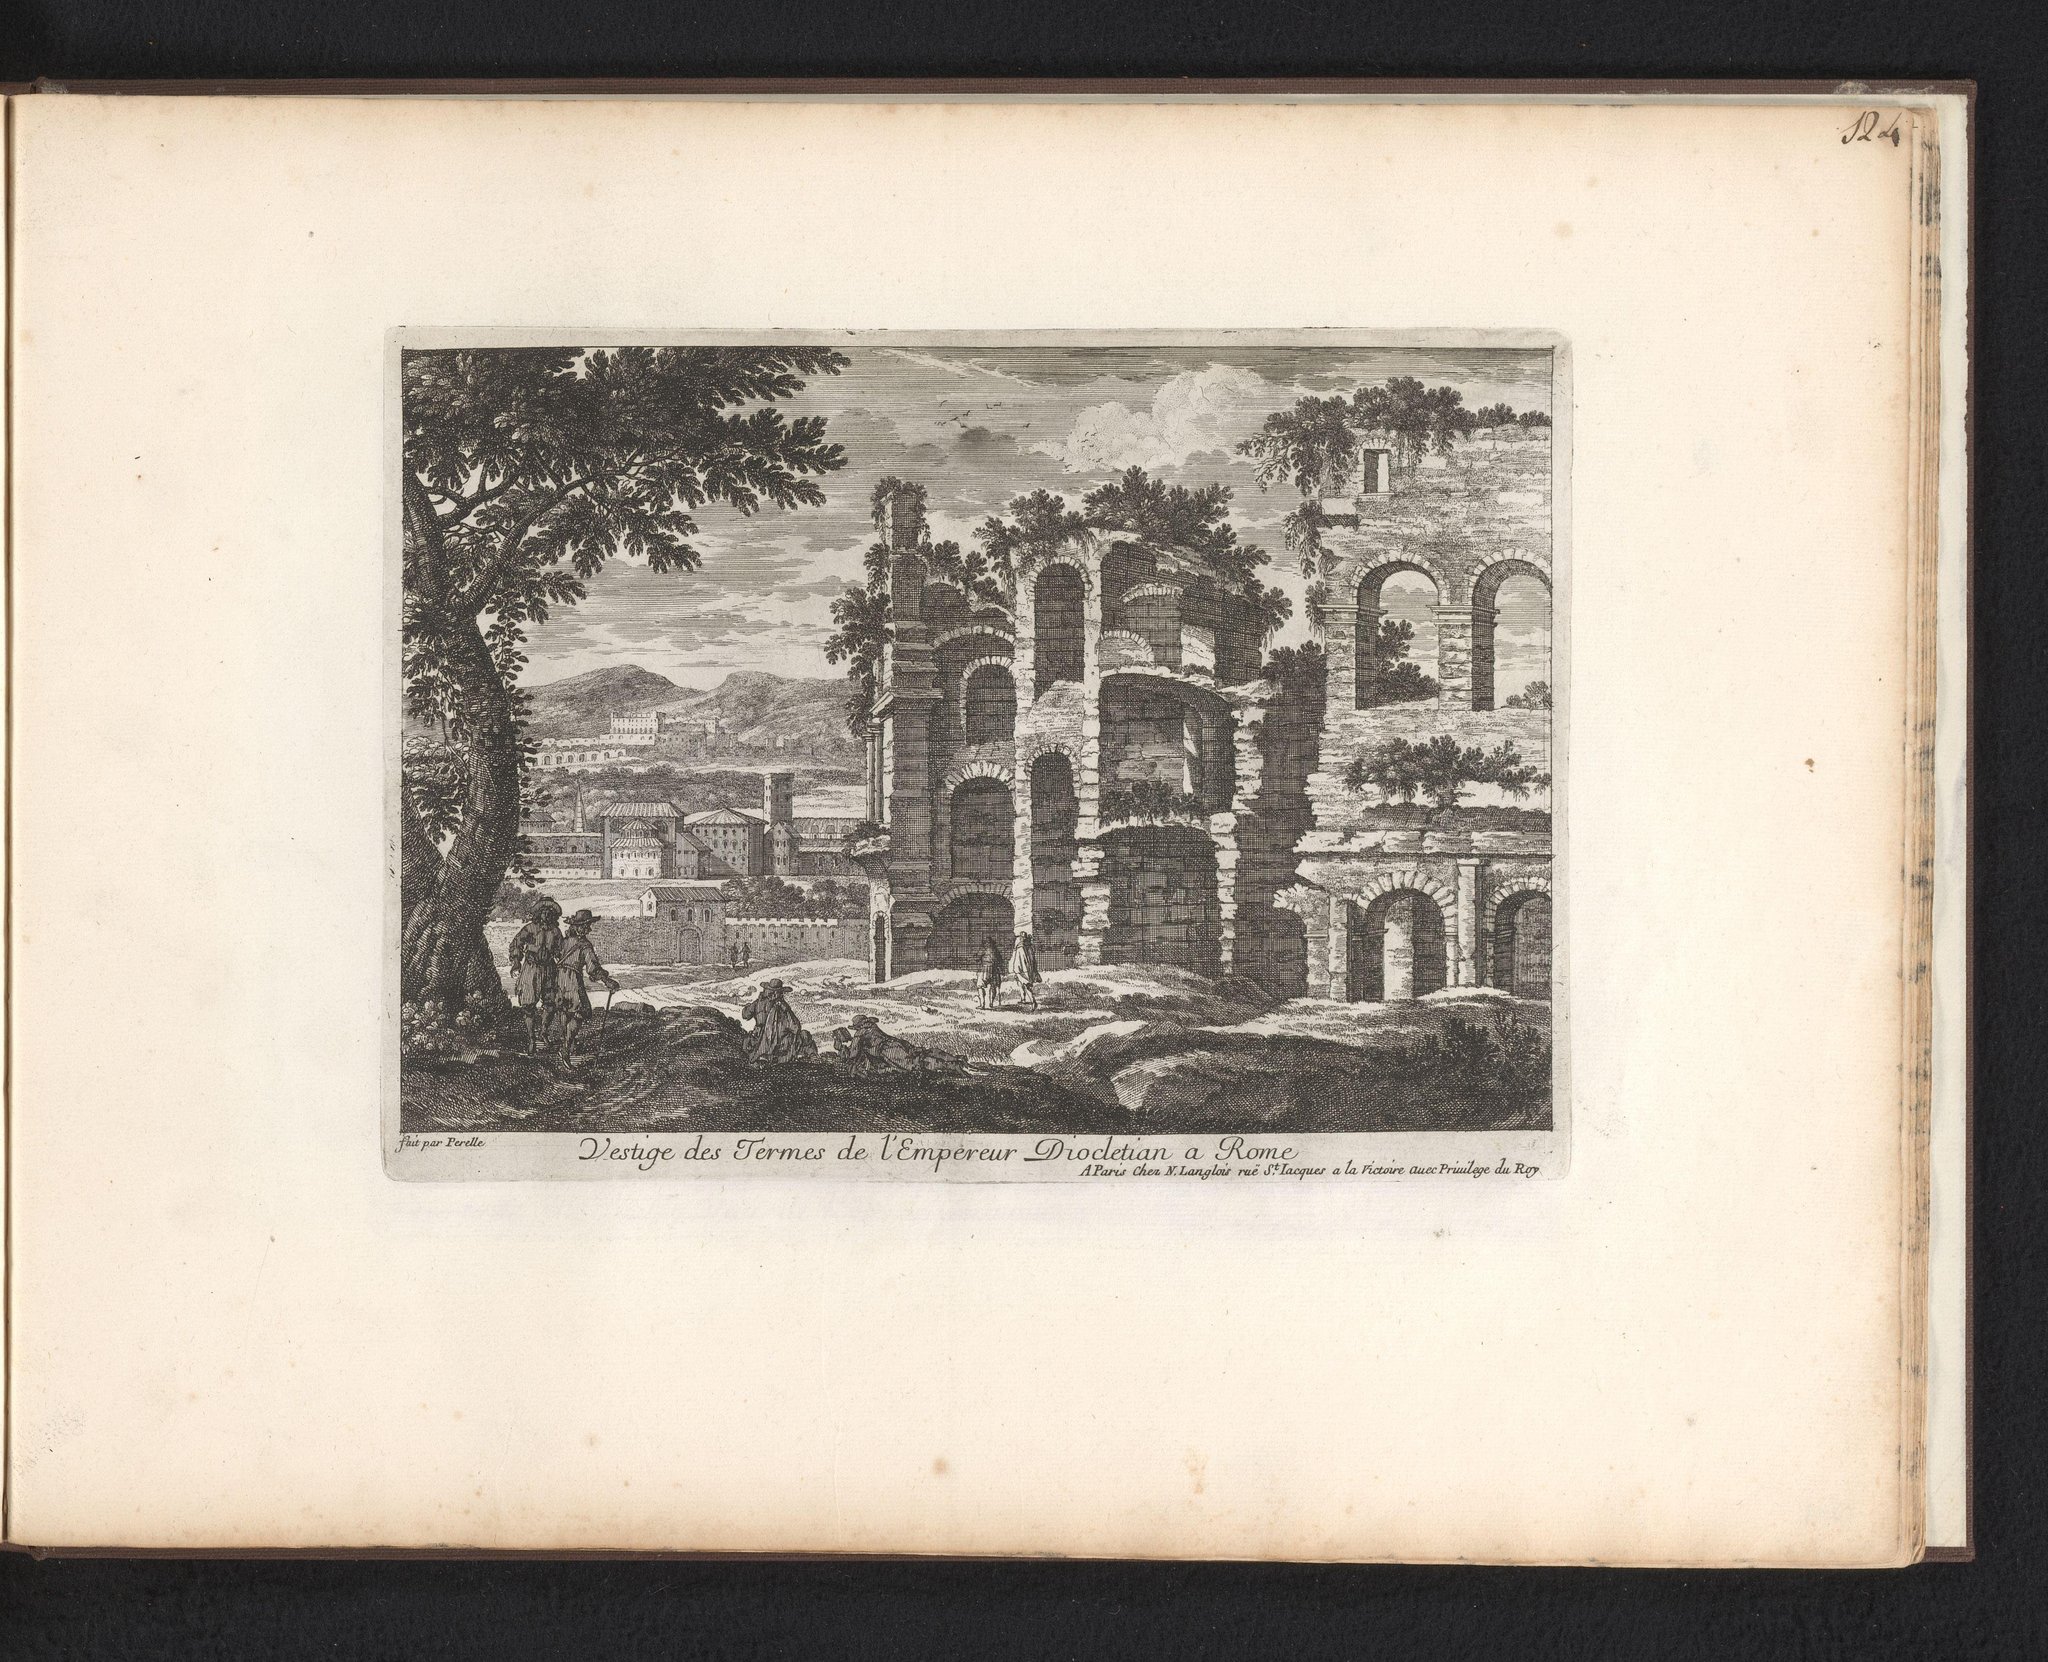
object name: print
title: Recueil de vues de monuments de Paris, des principales résidences royales et des principaux châteaux de France et de Rome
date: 1650-1695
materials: paper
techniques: etching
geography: paris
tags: landscape with ruins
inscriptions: collector's mark: Lugt 2228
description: Prenten met het signatuur 'Perelle' kunnen zowel door vader Gabriel als door zonen Nicolas en Adam gemaakt zijn. De uitgevers vader en zoon Nicolas Langlois worden allebei vermeld als N. Langlois op hetzelfde adres.